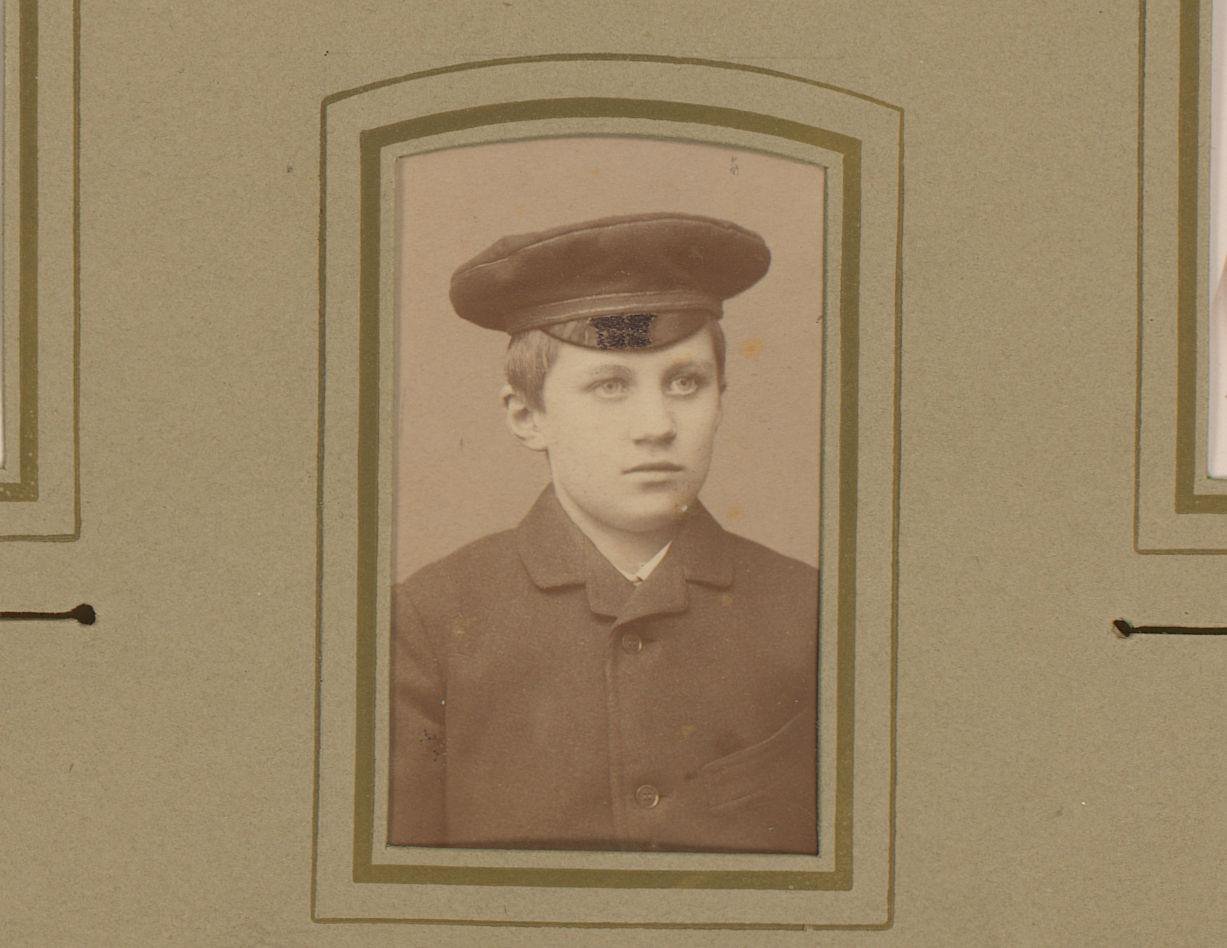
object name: carte de visite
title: Portret van een jongen met pet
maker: f. röhnert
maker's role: fotograaf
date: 1850-1900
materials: cardboard, photographic support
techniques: albumen print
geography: wolfenbüttel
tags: boy (child between toddler and youth), historical persons, head-gear: cap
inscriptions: inscription: ‘[F. R]ÖHNERT/ A[...] PHOTOGRAPH/ [...]’